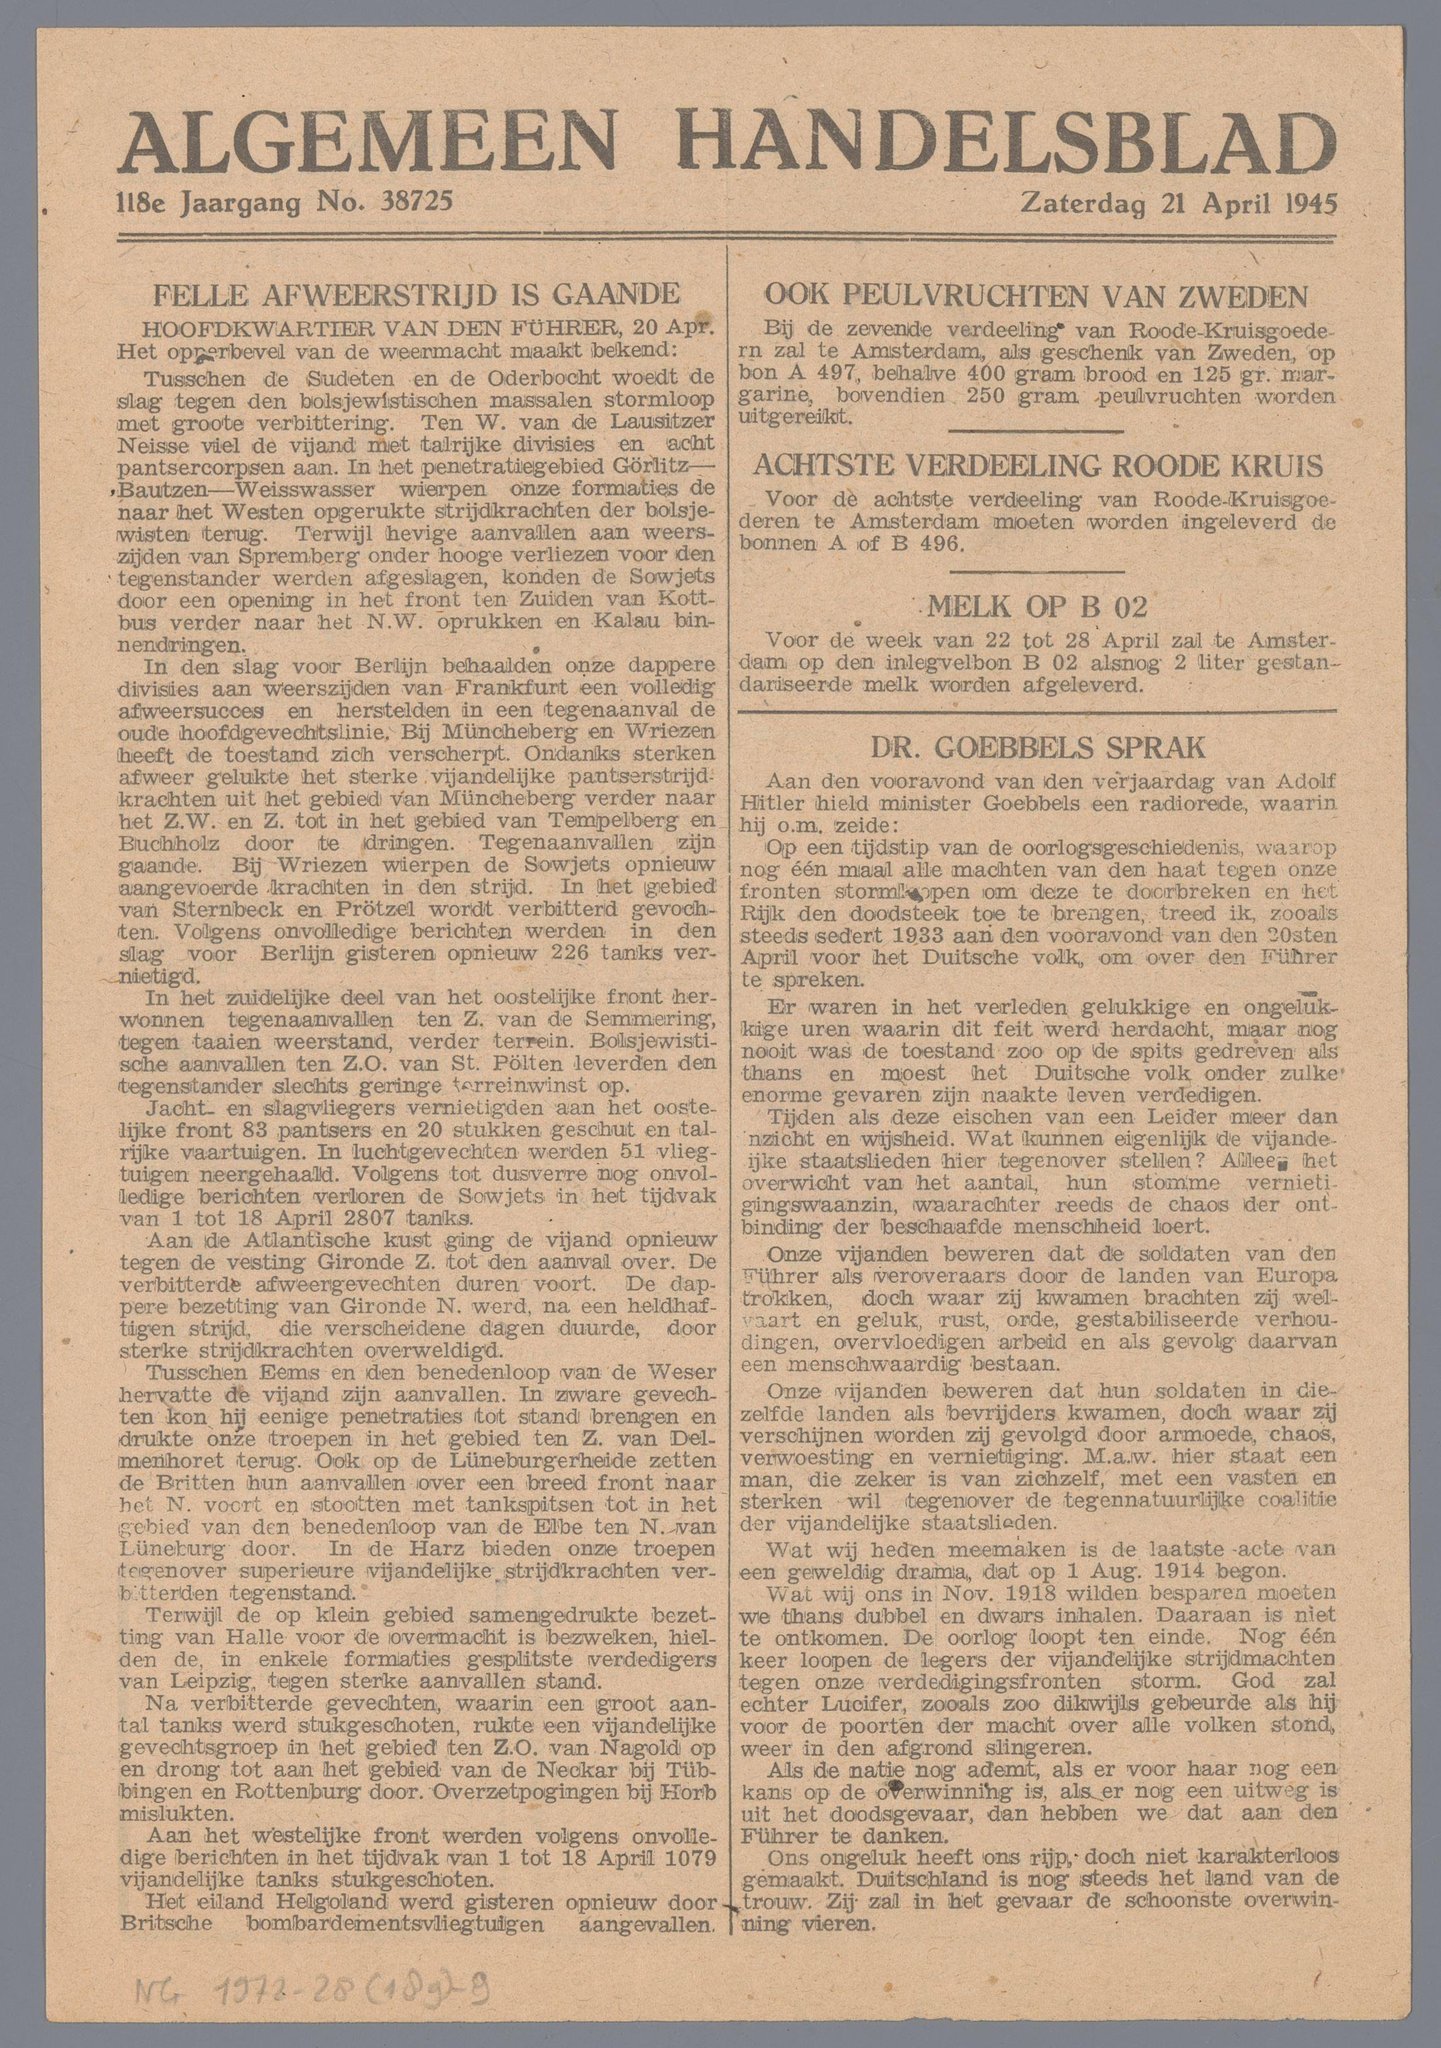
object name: newspaper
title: Algemeen Handelsblad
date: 1945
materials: paper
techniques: printing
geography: amsterdam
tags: tweede wereldoorlog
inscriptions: date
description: Krant, klein formaat, met bericht over de oorlog uit Duits gezinde hoek. Gedateerd: Zaterdag, 21-04-1945.